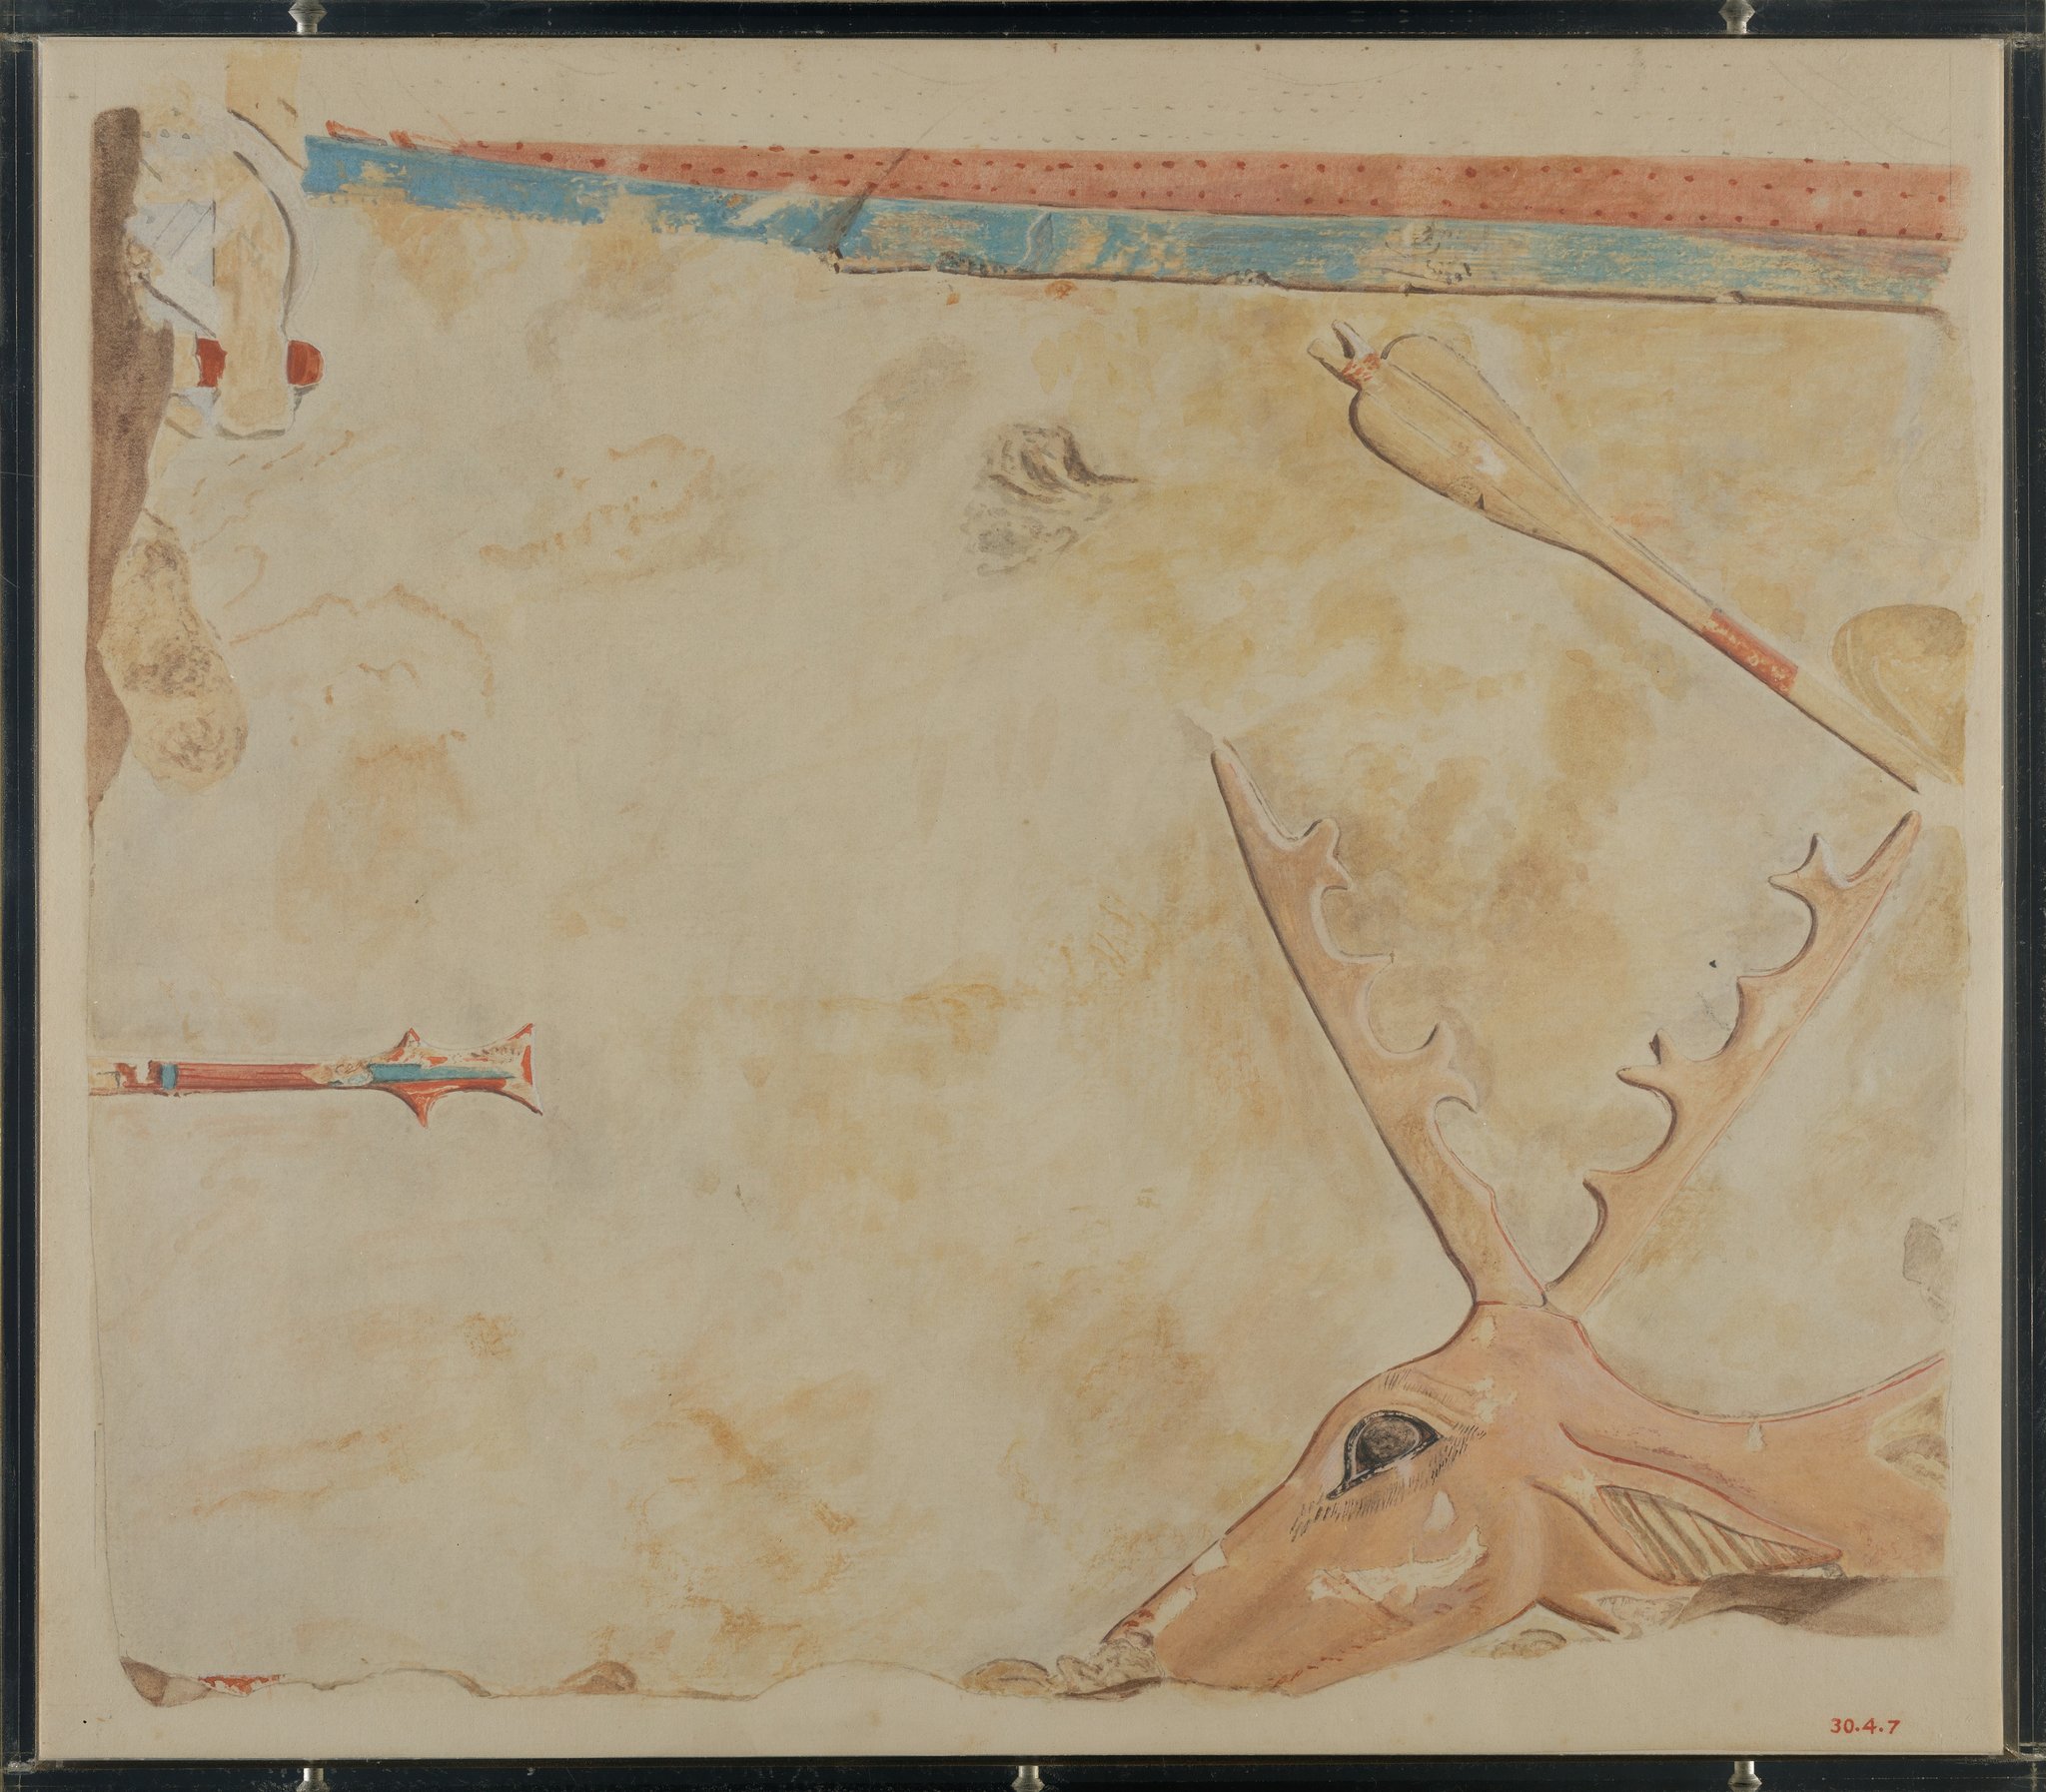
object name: facsimile, mentuherkhepeshef tt 20, hunting, antelope, arrow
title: Fragment of a Hunting Scene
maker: norman de garis davies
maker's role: artist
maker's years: 1865-1941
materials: paper, paint